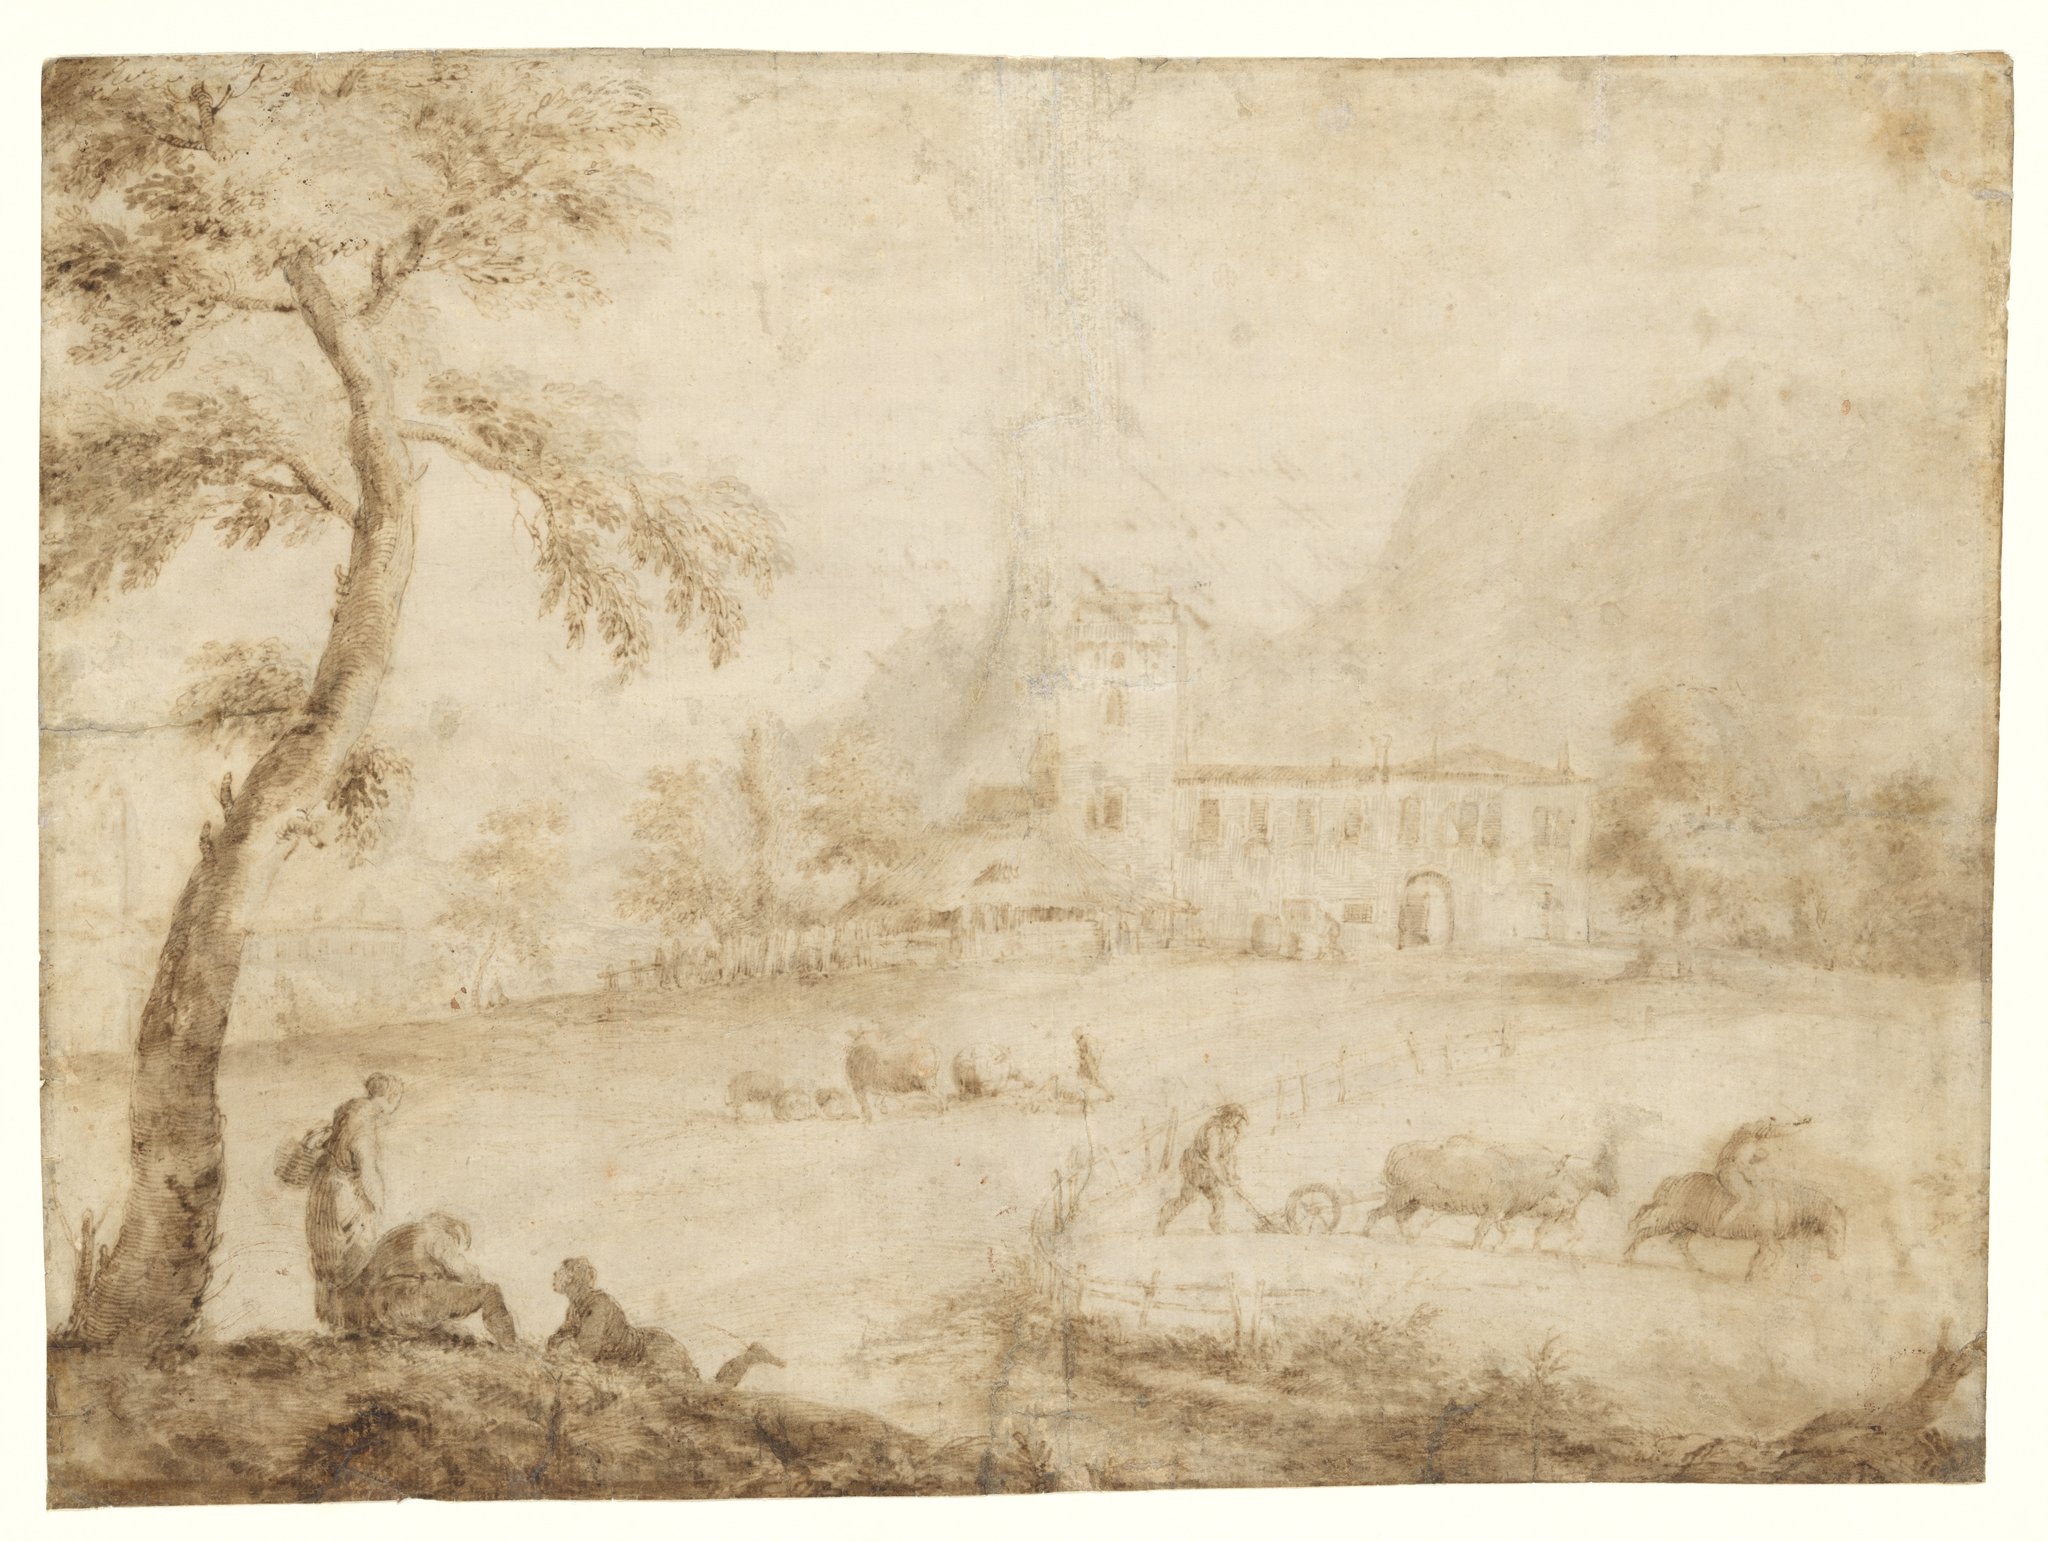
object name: drawing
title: The House of Marco Ricci in the Bellunese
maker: marco ricci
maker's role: artist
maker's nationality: italian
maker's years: 1676-1730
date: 1726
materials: ink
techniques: pen, wash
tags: animals,houses,landscapes